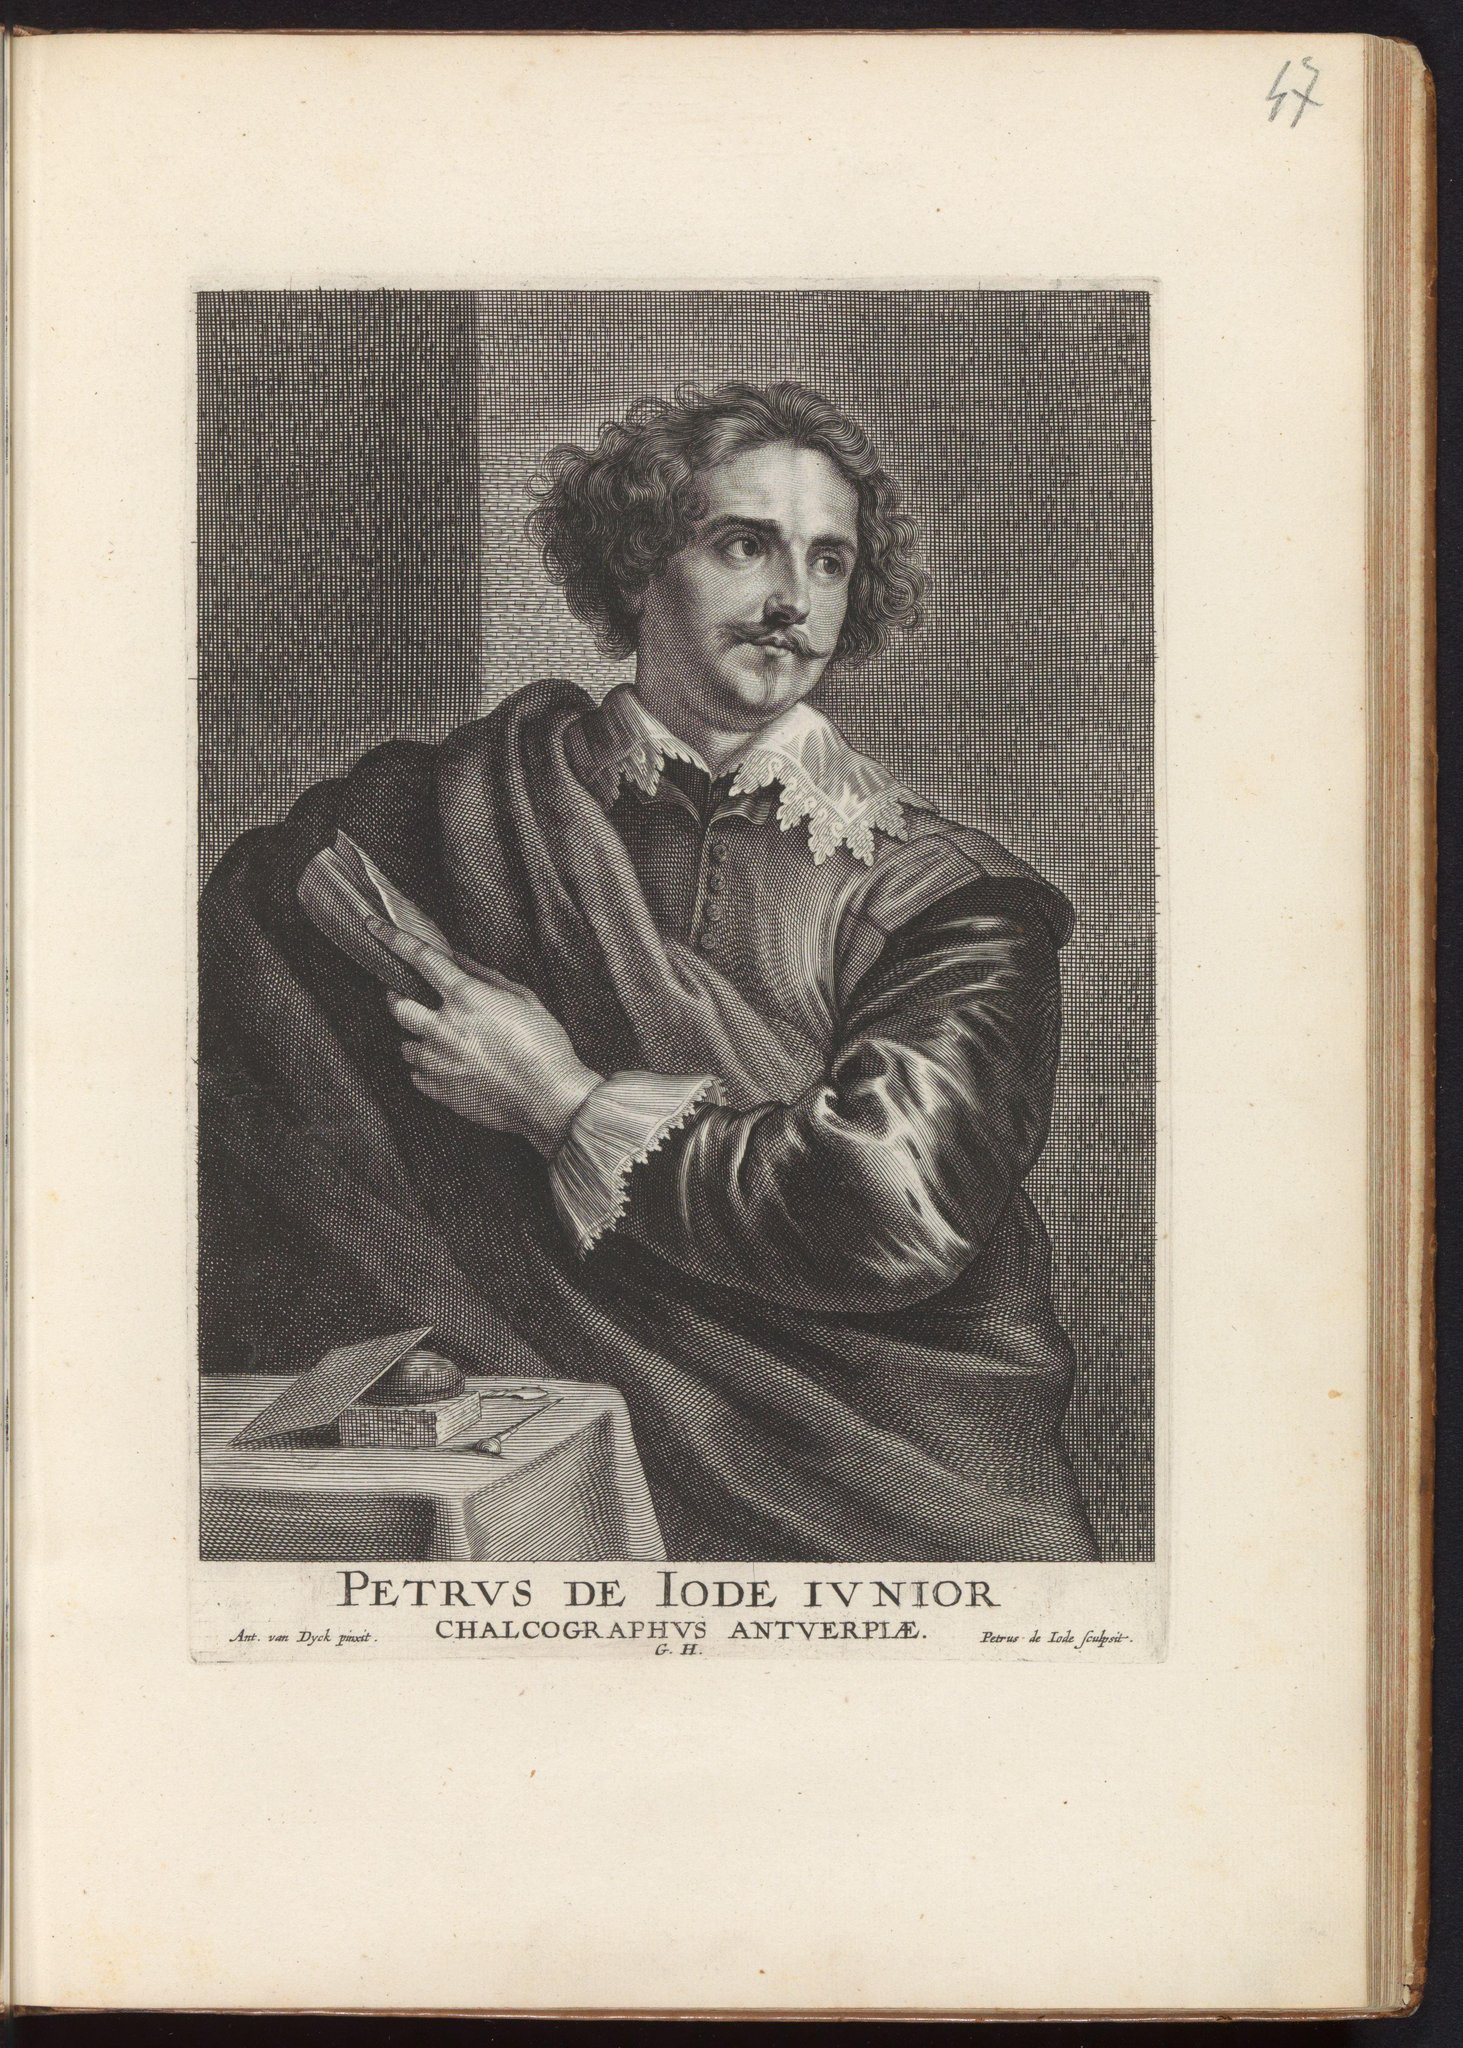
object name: print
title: Portret van Pieter de Jode de Jonge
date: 1630-1641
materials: paper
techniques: engraving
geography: antwerp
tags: tools, implements of graphic artist, portrait, self-portrait of graphic artist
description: Portret van de kunstenaar Pieter de Jode de Jonge. In zijn linkerhand houdt hij een opgerold vel papier. Op de tafel voor hem een graveernaald en andere attributen. Deze prent maakt deel uit van een album.